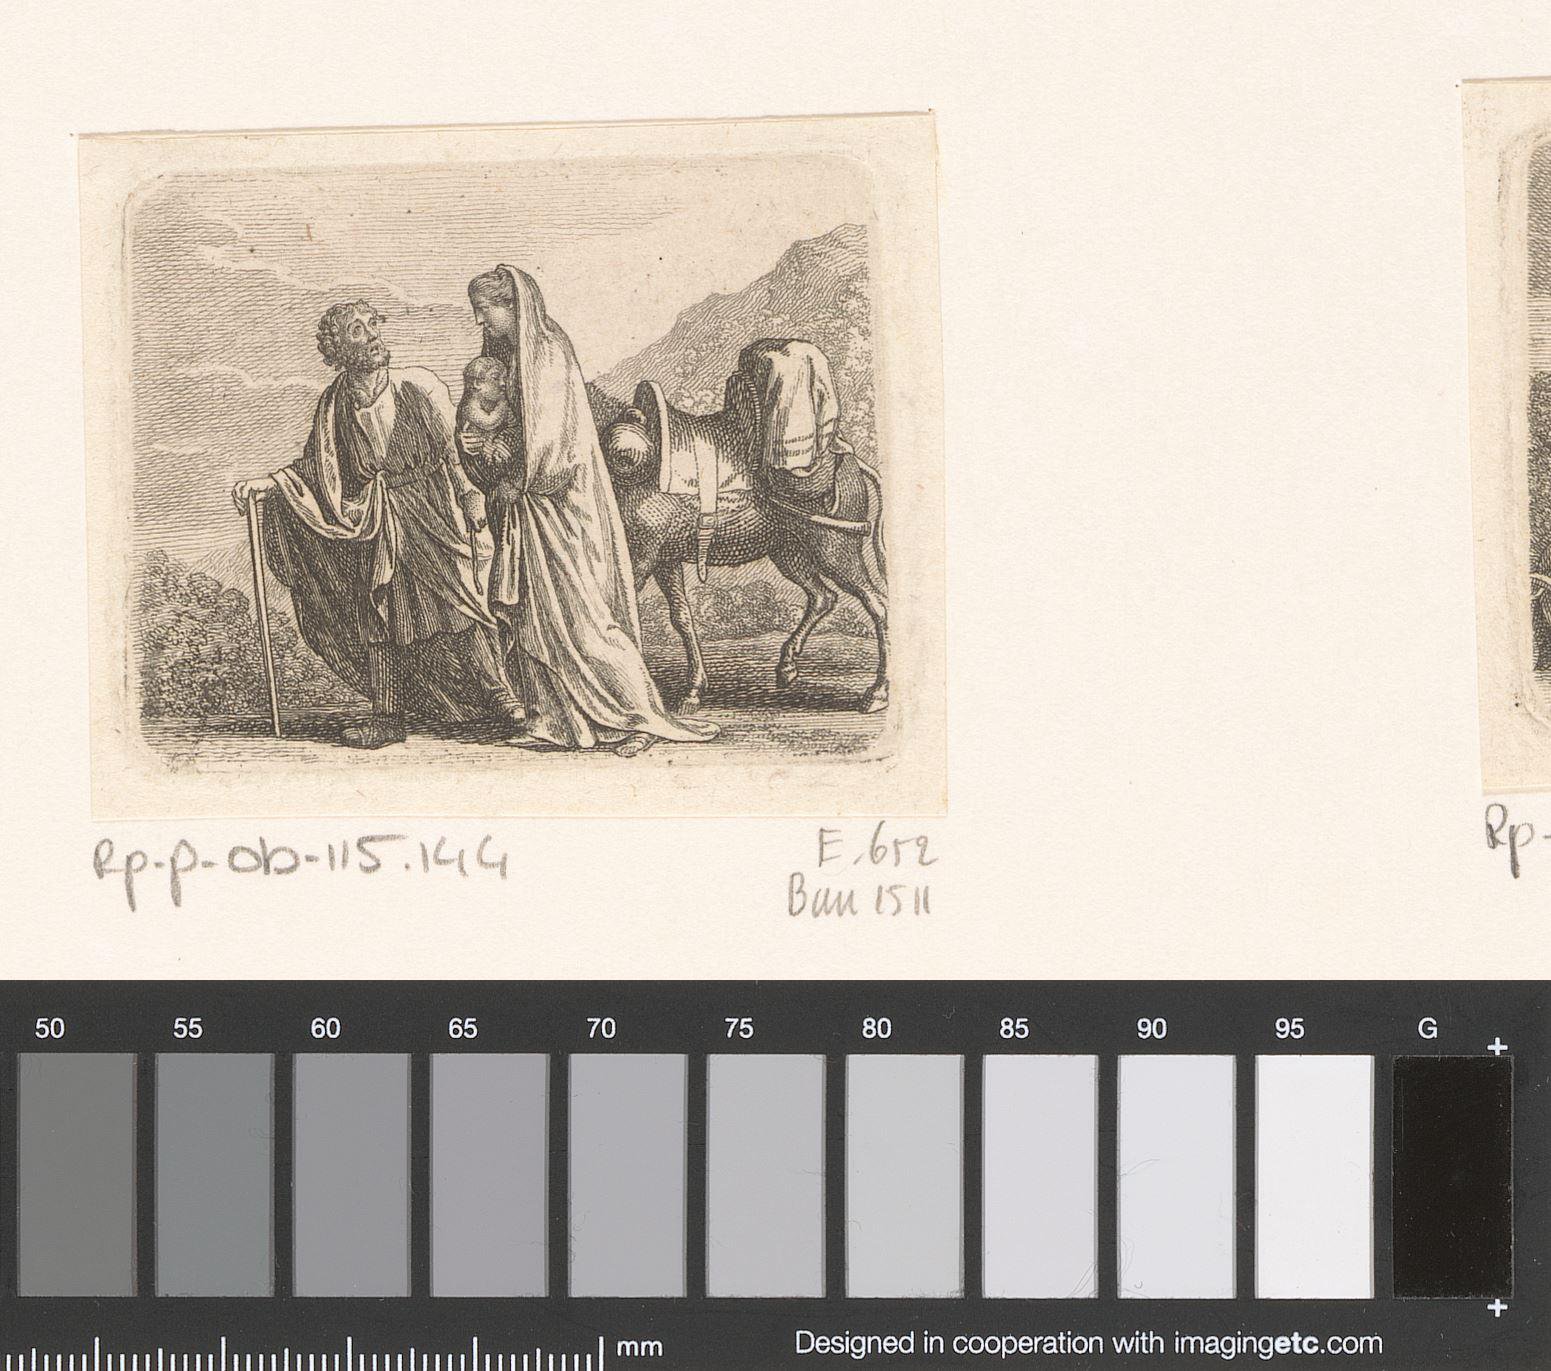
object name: print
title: Vlucht naar Egypte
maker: daniel nikolaus chodowiecki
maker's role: draughtsman, print maker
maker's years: 1726-1801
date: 1790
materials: paper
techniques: etching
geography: berlin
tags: the flight into egypt: mary, joseph, the child (and sometimes others) on their way; mary usually riding on an ass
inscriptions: collector's mark: Lugt 2228